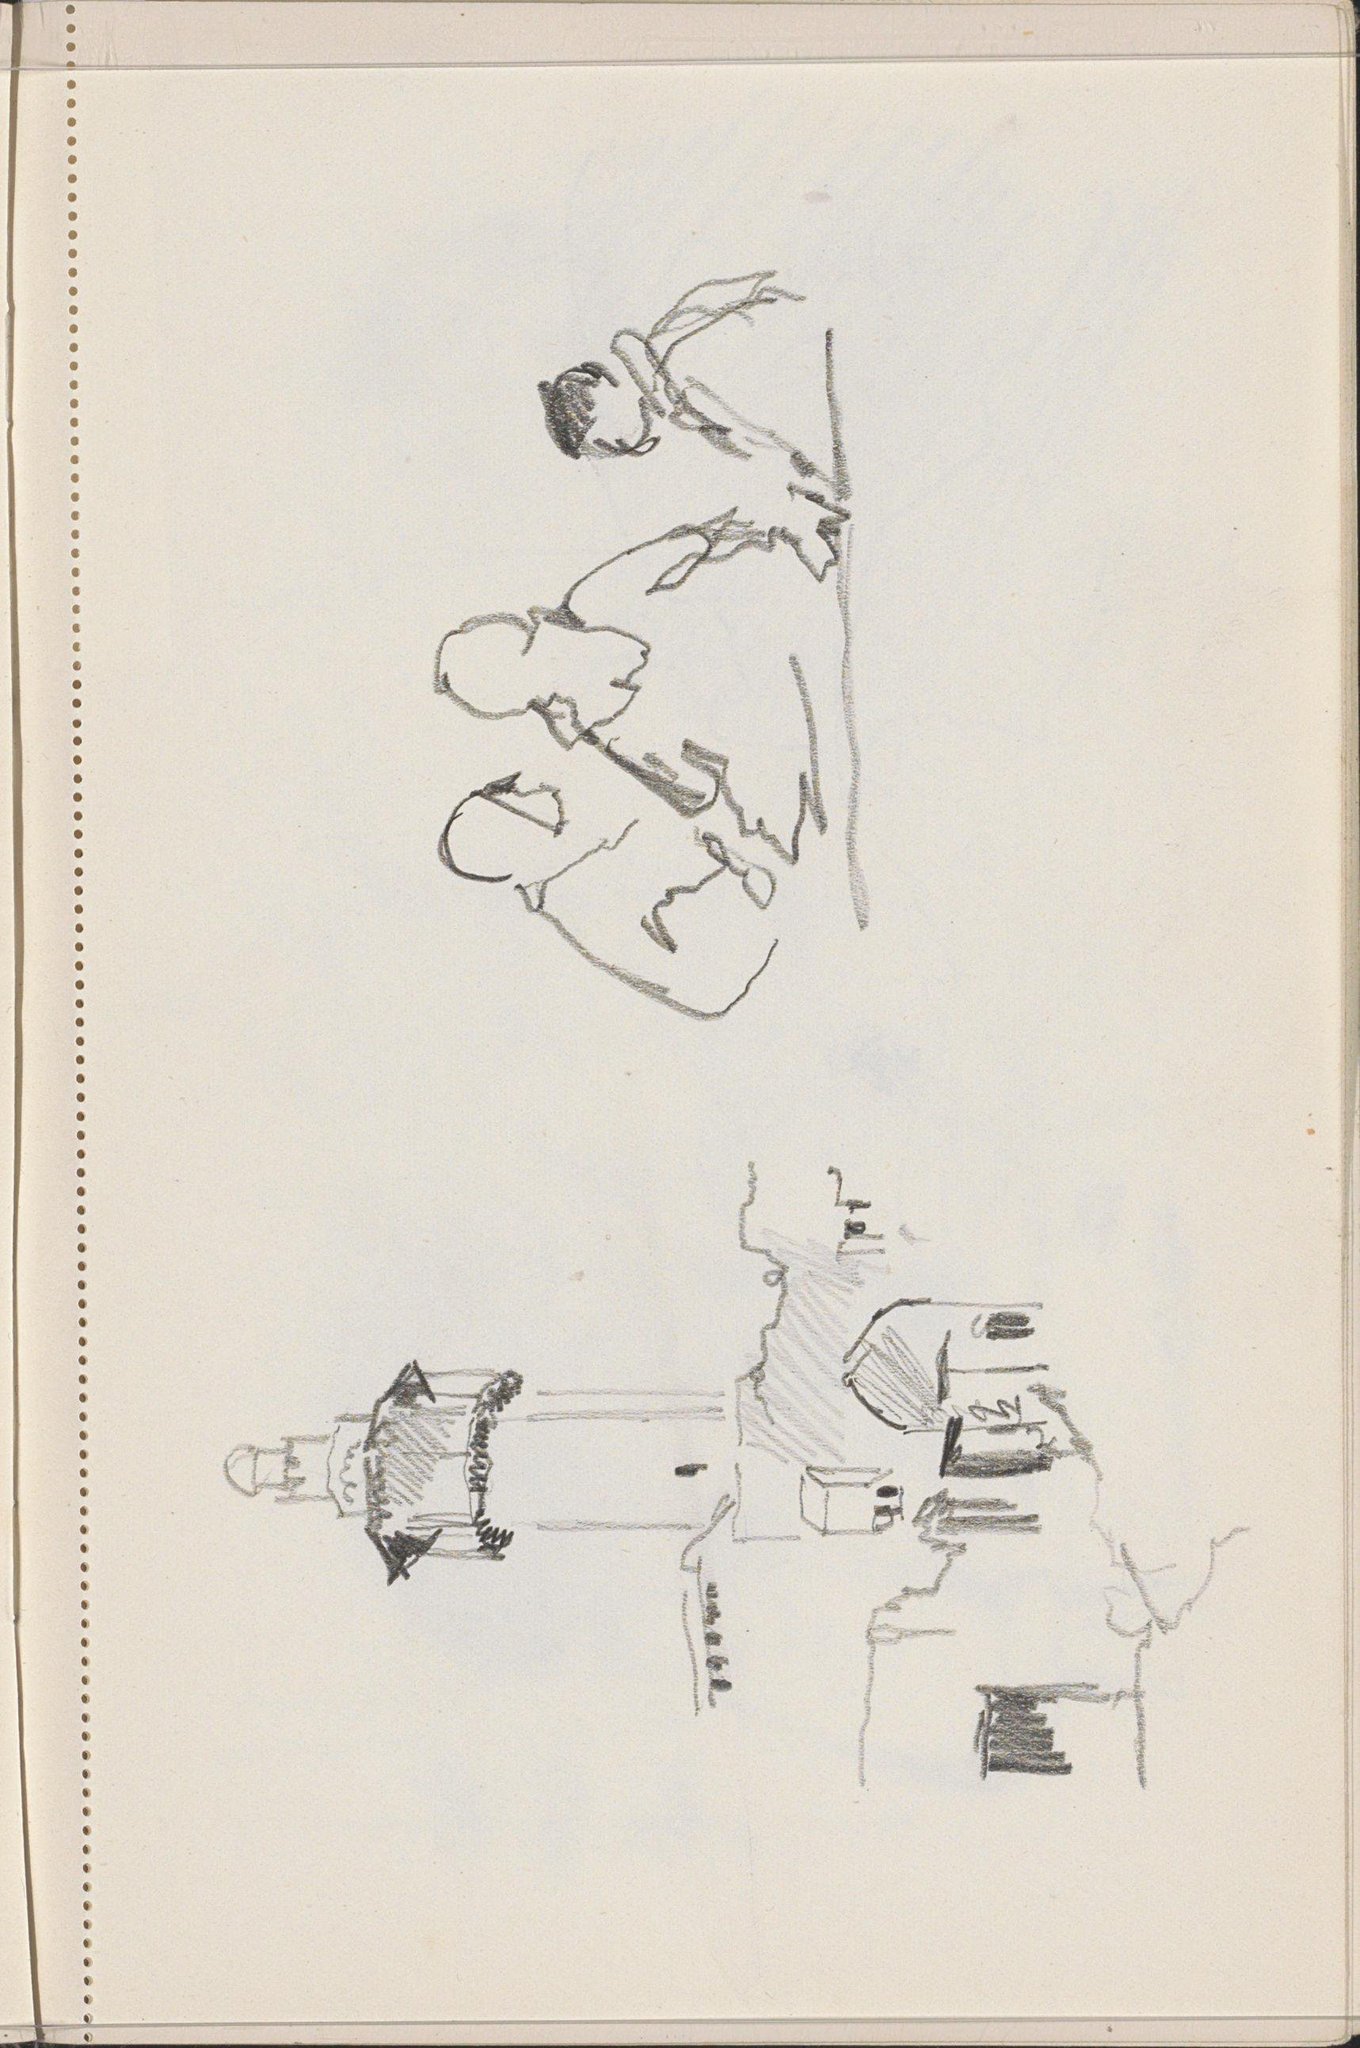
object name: sketchbook leaf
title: Toren van een moskee in een straat en zittende figuren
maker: cornelis vreedenburgh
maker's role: draughtsman, print maker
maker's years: 1880-1946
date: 1936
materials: paper, pencil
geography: maghreb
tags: sitting figure, folk costume, regional costume, temple, shrine ~ islam, mohammedanism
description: De figuren dragen lange gewaden en hoofddoeken. Blad 49 recto uit een schetsboek met 73 bladen.